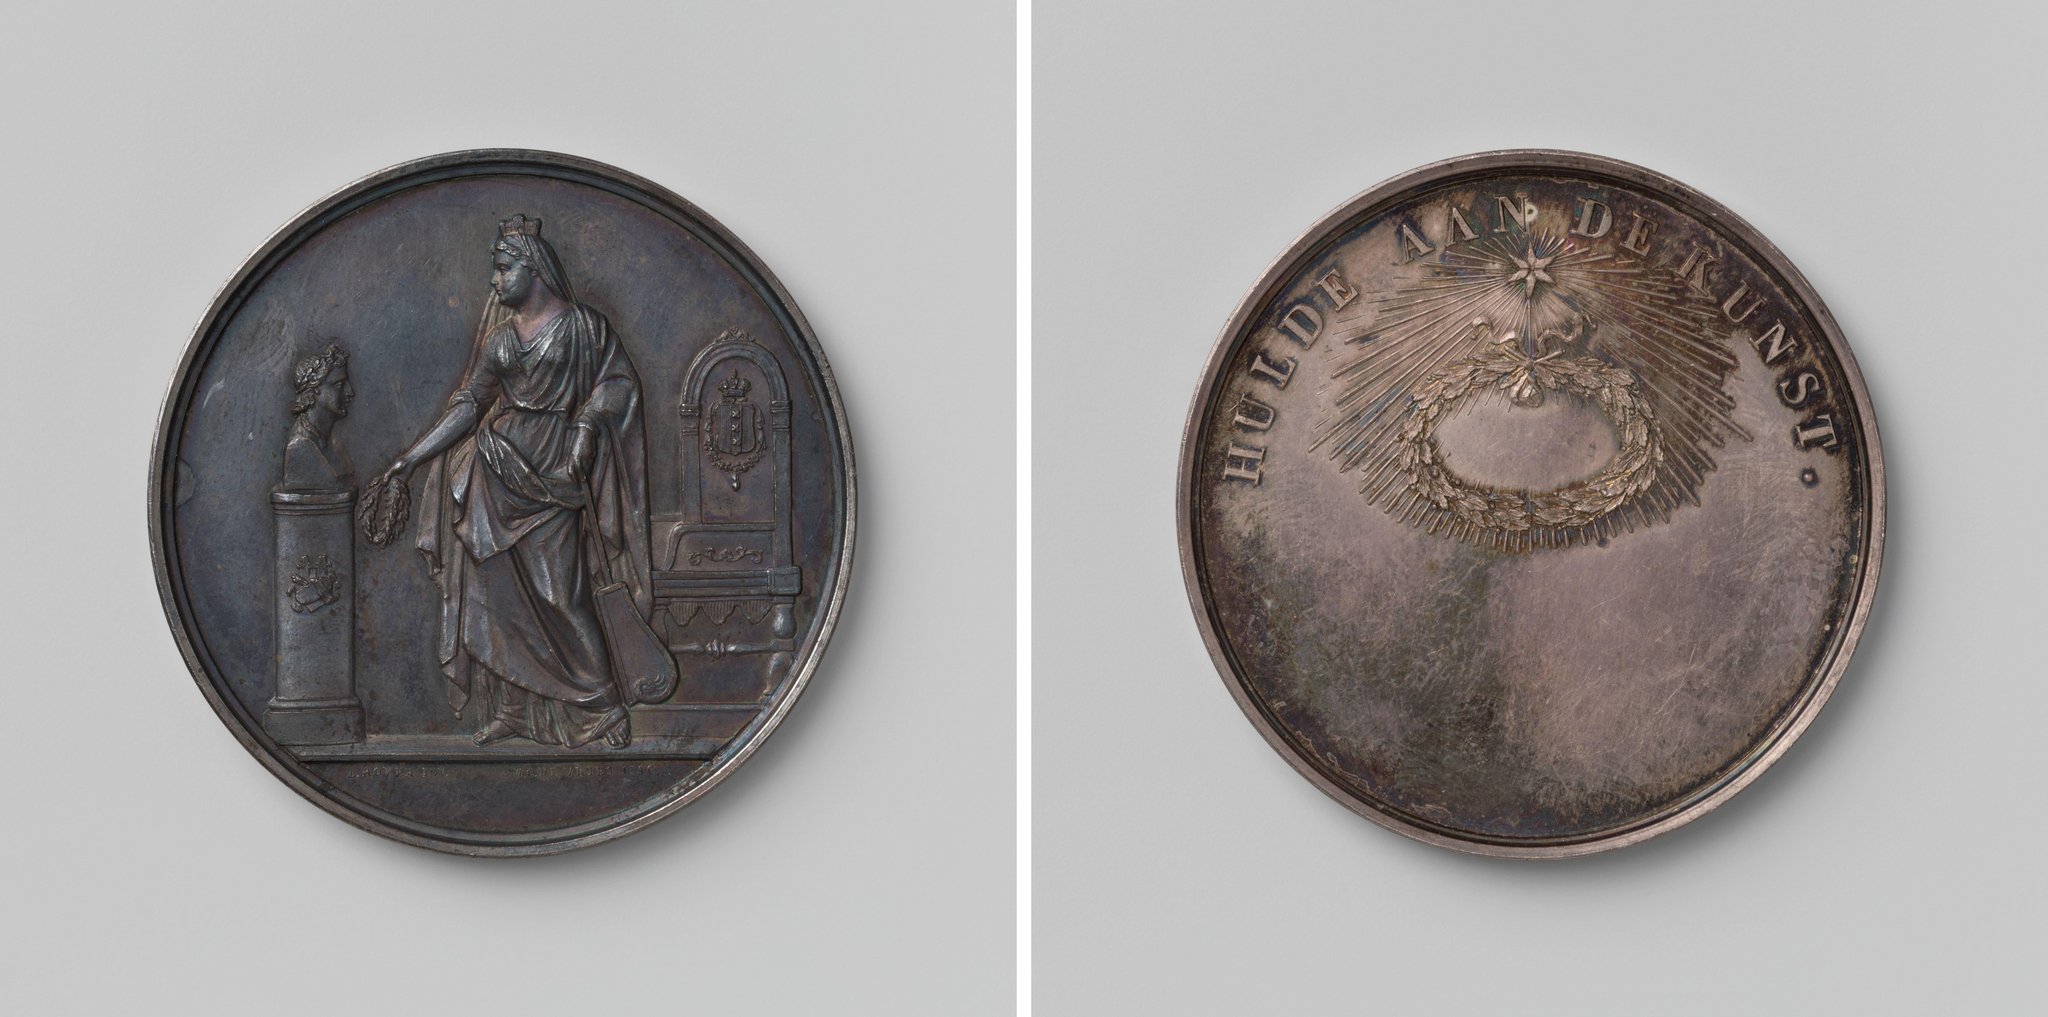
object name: medal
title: Internationale tentoonstelling van schilderkunst te Amsterdam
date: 1860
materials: silver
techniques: striking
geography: amsterdam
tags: amsterdam